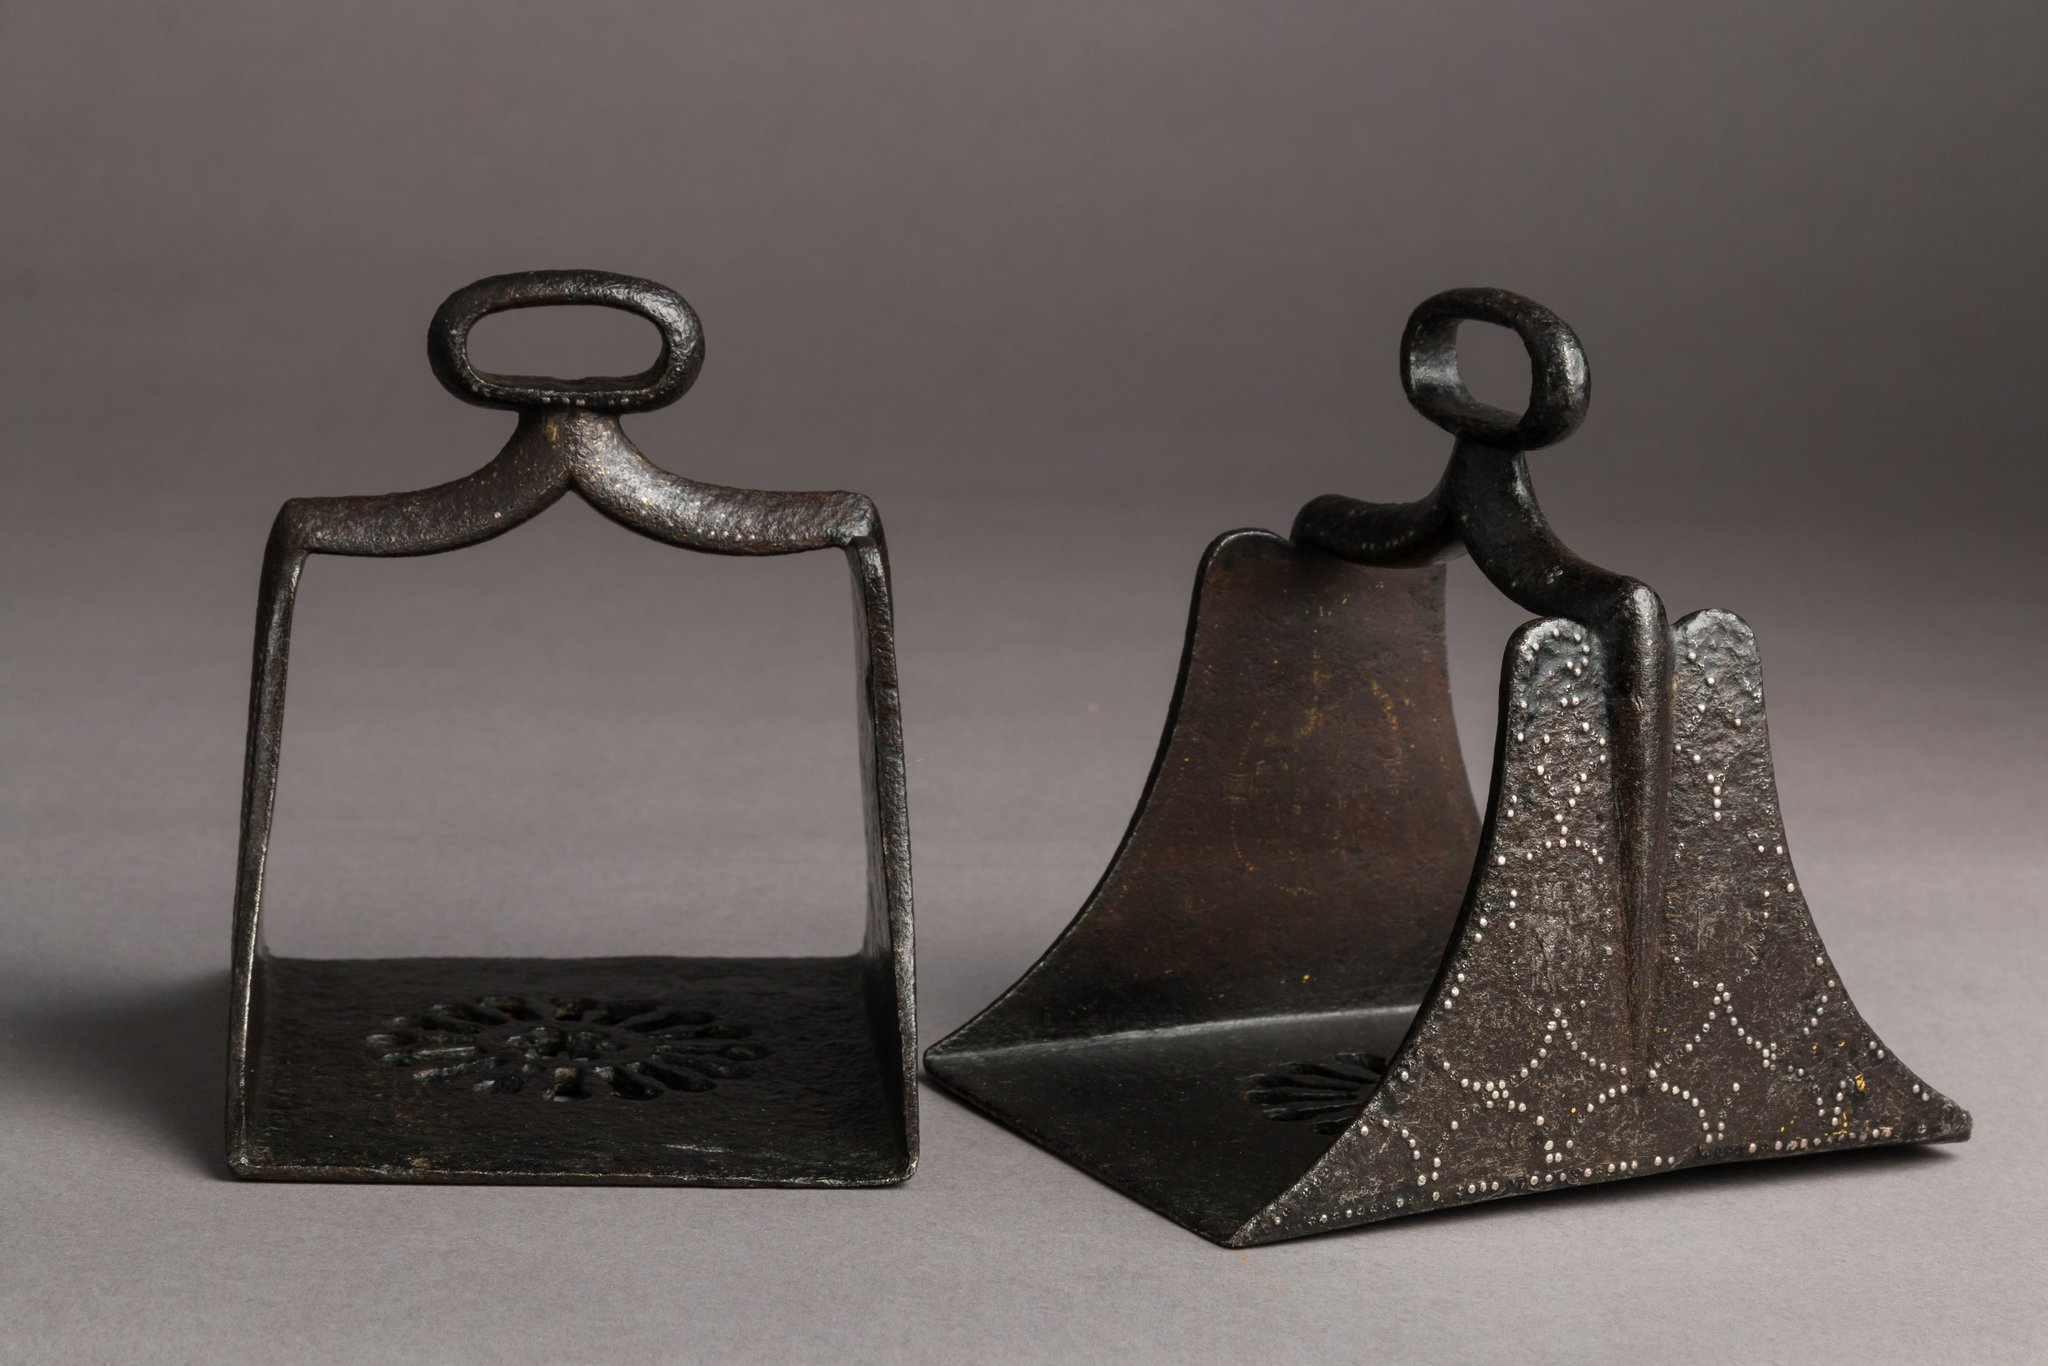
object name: stirrup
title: Pair of Stirrups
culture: italian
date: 1567-1600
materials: gold, iron, silver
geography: italy